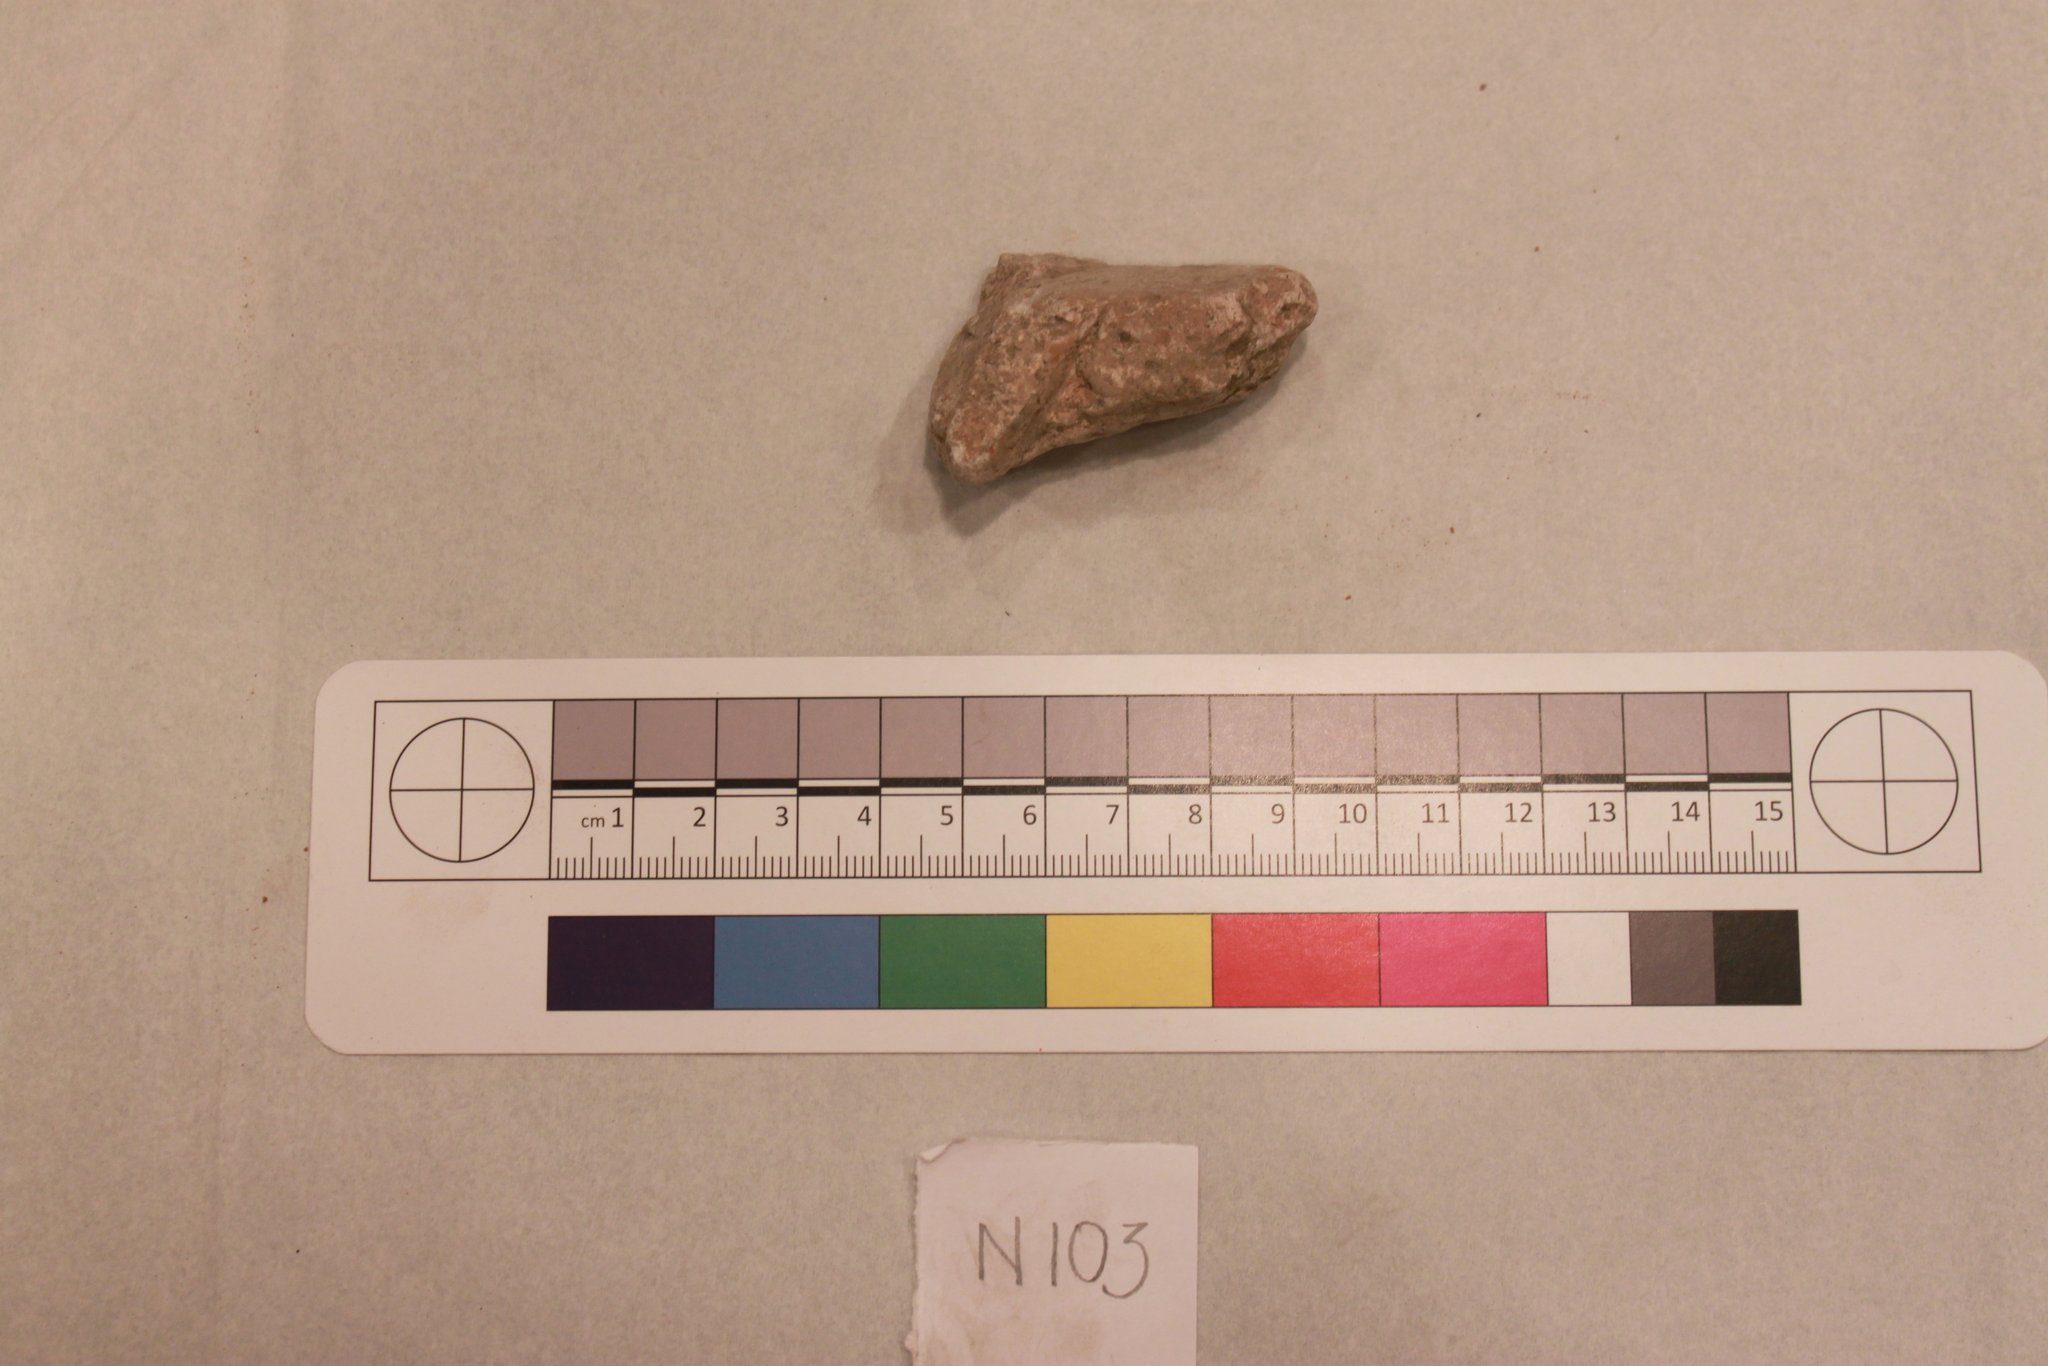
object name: fragment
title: Stucco Fragment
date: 701-1200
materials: plaster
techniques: carving, painting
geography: iran